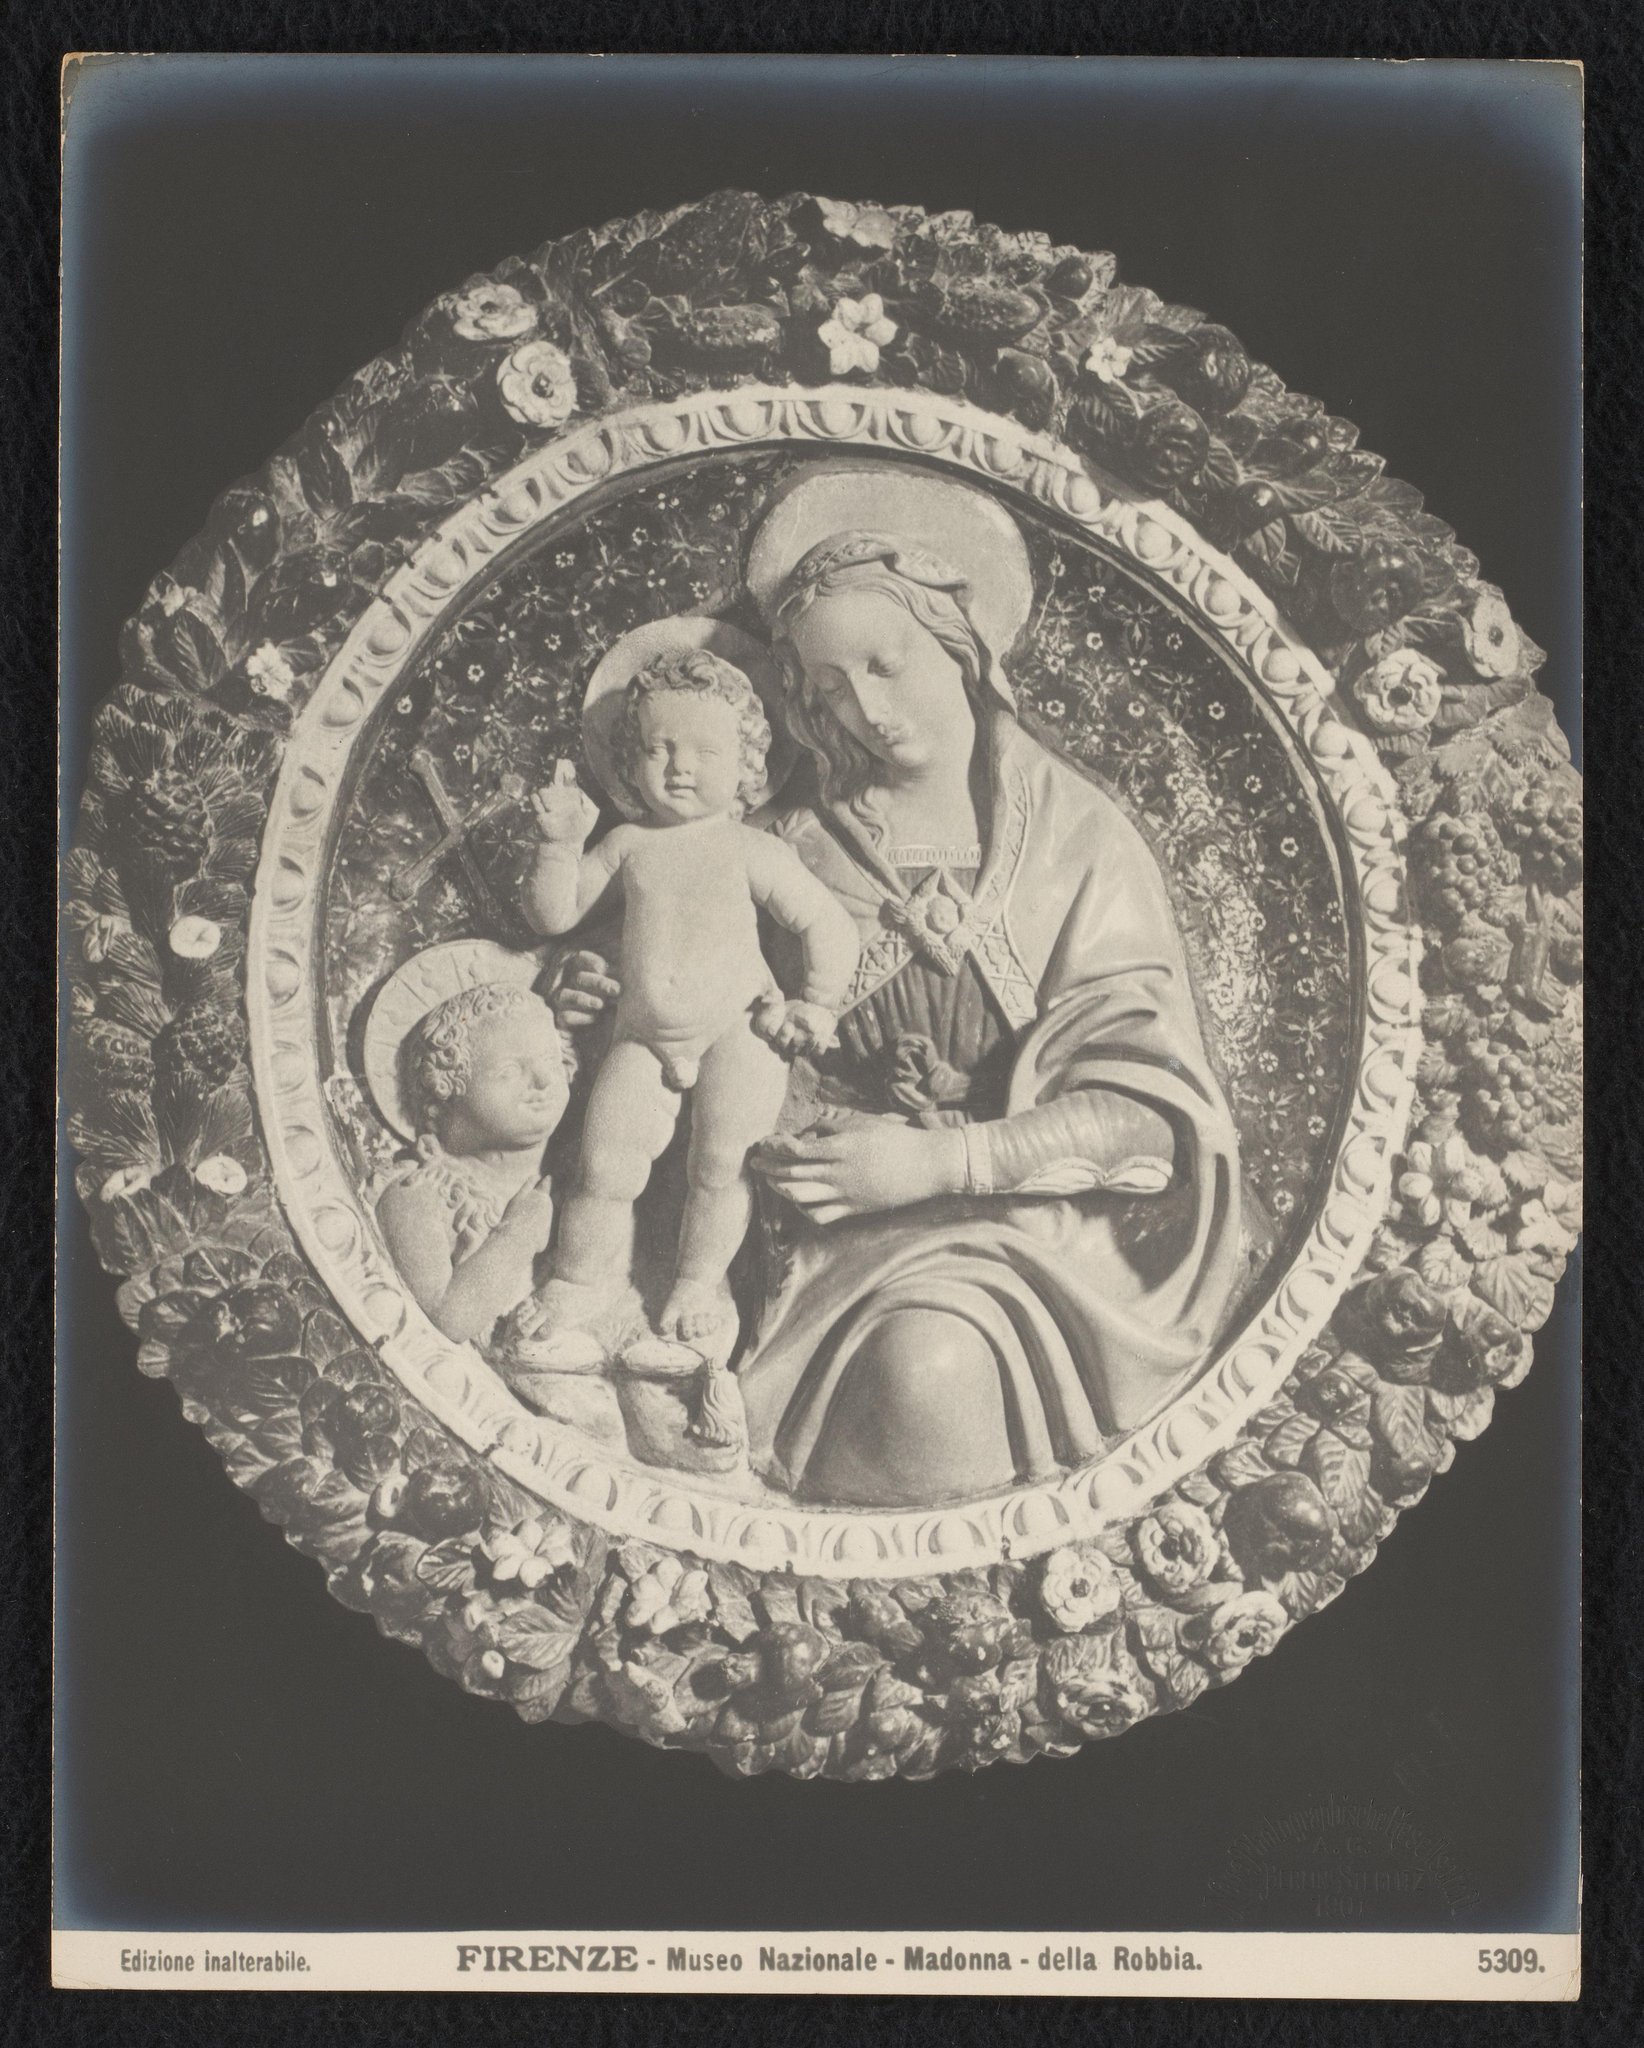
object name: photograph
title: Reliëf van Madonna door Giovanni della Robbia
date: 1901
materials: paper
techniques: gelatin silver print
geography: florence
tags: madonna: i.e. mary with the christ-child, sculpture (+ relief ~ sculpture)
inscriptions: inscription: ‘Edizione inalterabile.’, collector's mark: ‘RIJKS SCHOOL VOOR KUNSTNIJVERHEID/ GROEP’, number: ‘5309.’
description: Deze foto maakt deel uit van een omslag.